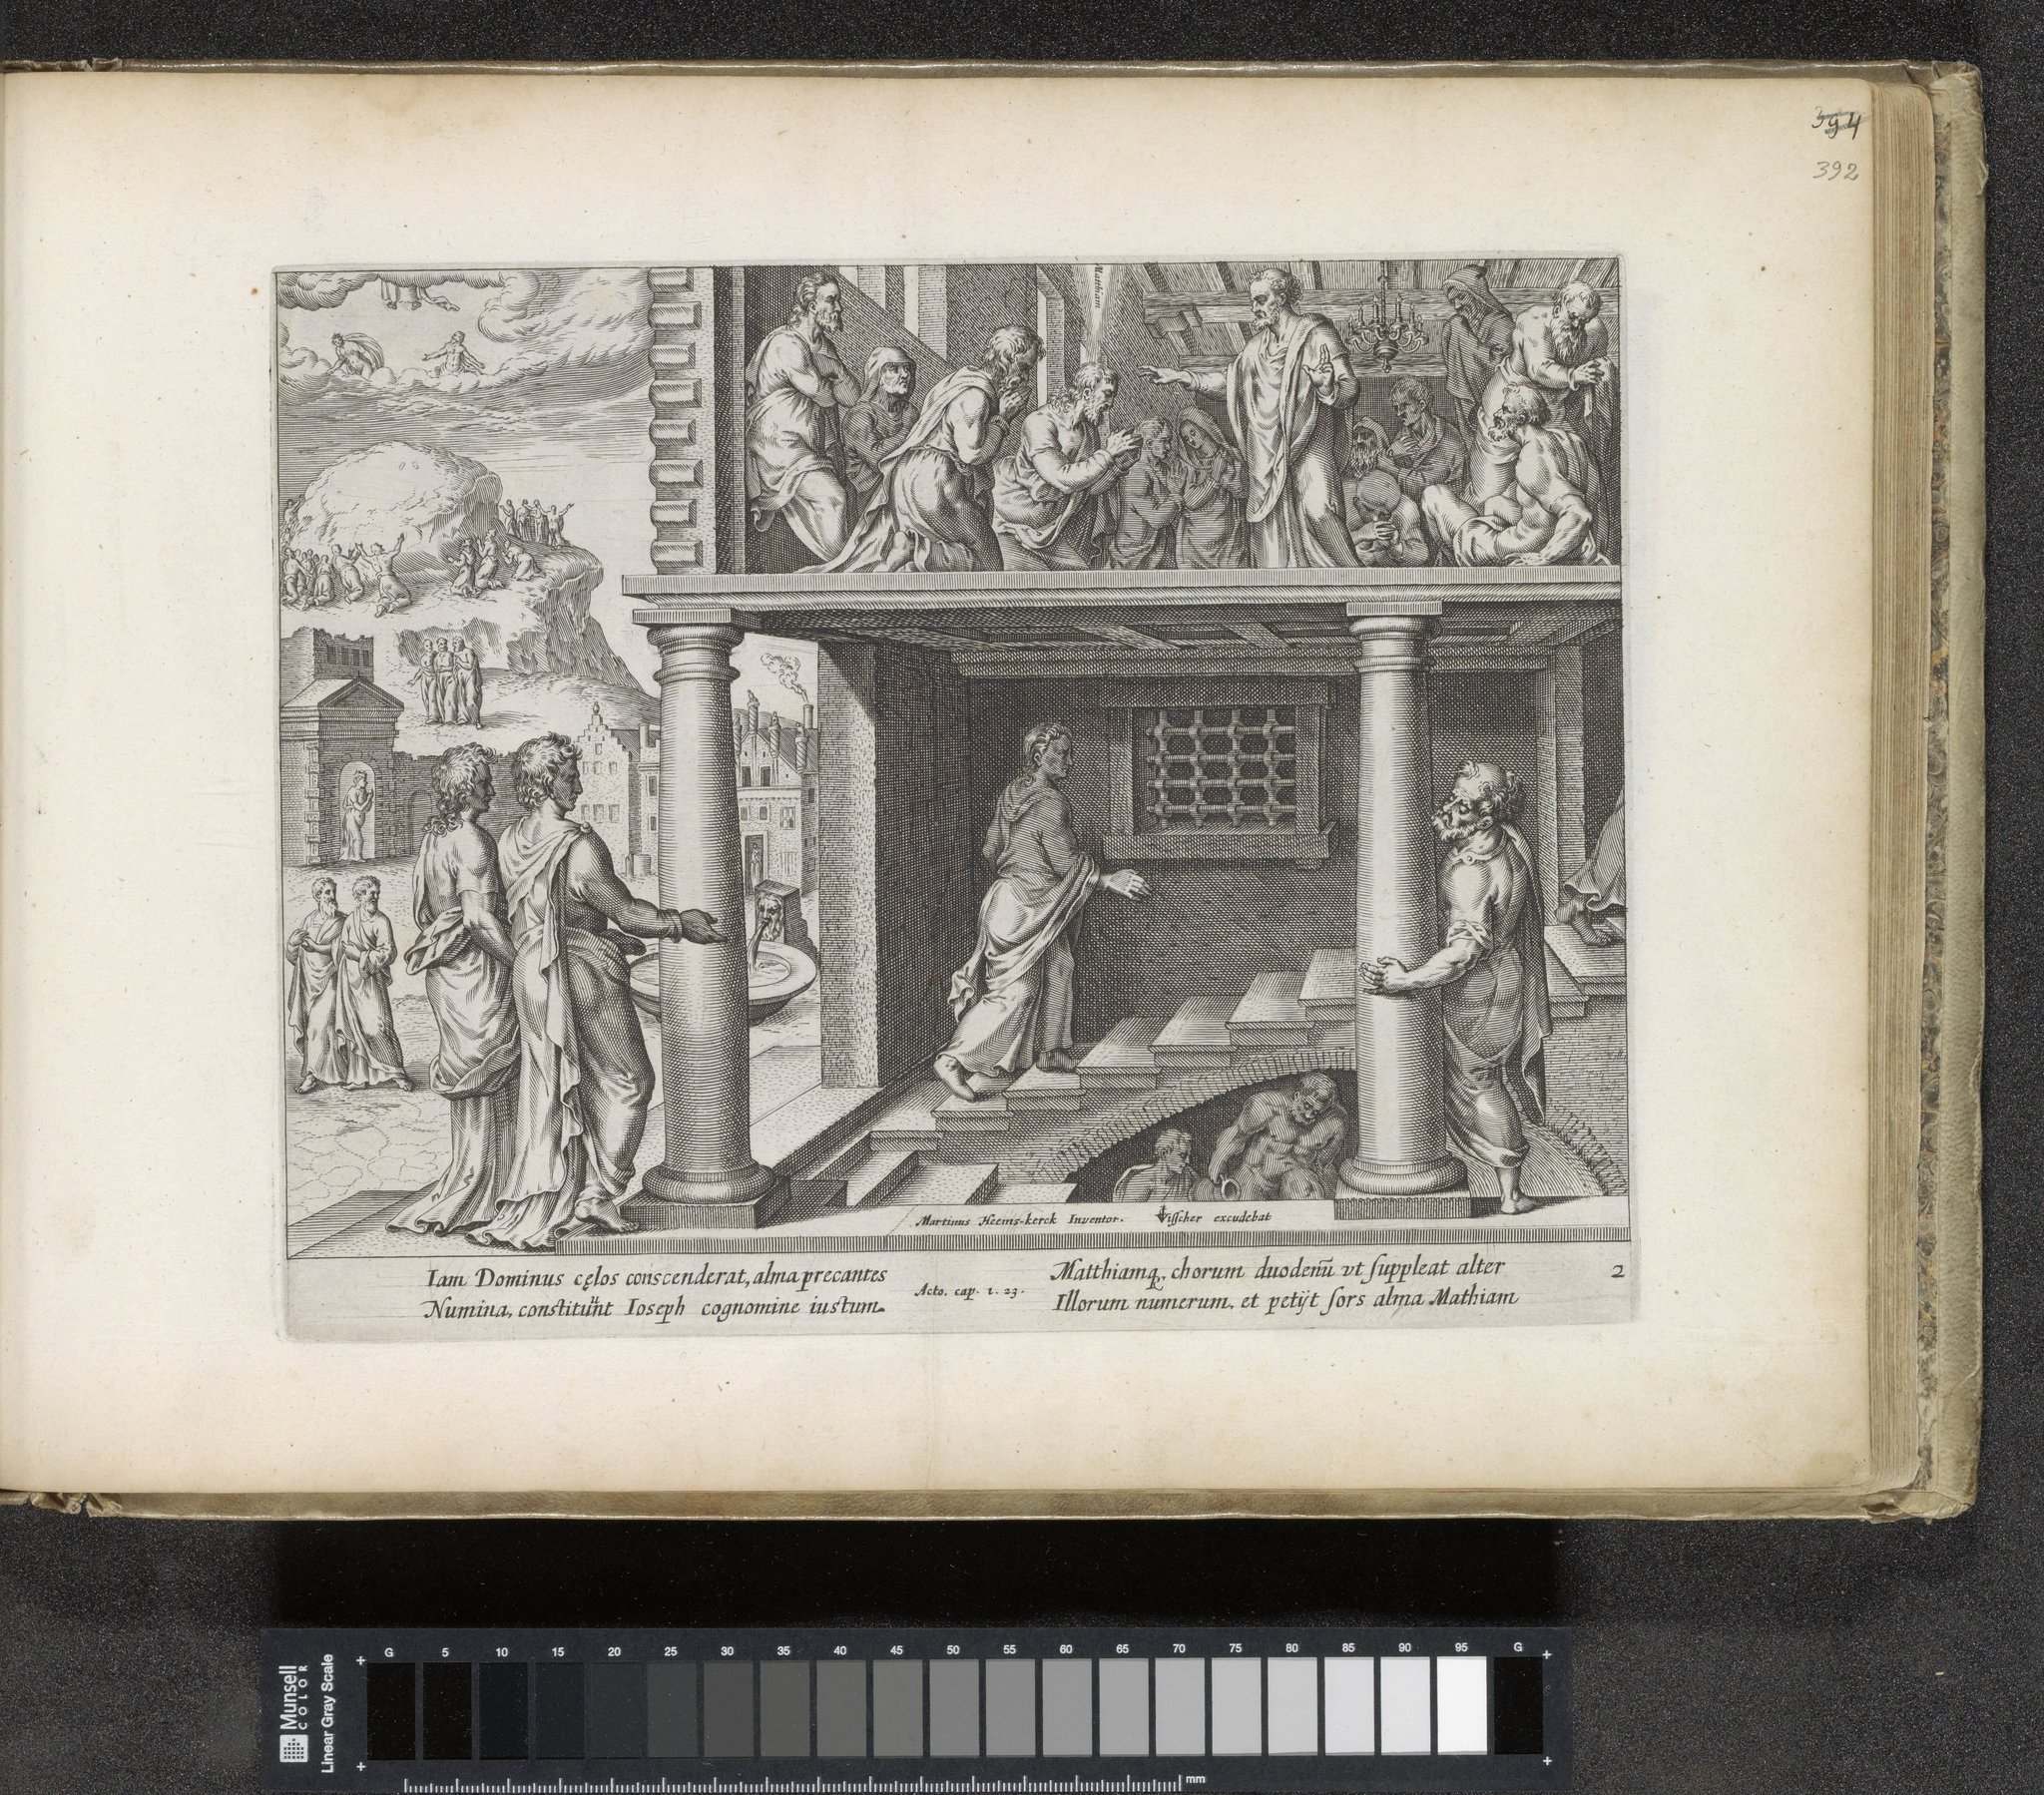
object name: album leaf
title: Hemelvaart van Christus en verkiezing van Mattias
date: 1643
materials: paper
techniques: engraving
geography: amsterdam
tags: the ascension (christ surrounded by radiant light or in a mandorla), peter, in the midst of the disciples, proposes choosing an apostle to take judas' place (acts 1:15-26)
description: Op de achtergrond de Hemelvaart van Christus op de Olijfberg. Op de voorgrond keren de apostelen terug naar Jeruzalem. Petrus wijst Mattias aan als twaalfde apostel. Onder de voorstelling een verwijzing in het Latijn naar de Bijbeltekst in Hand. 1:23. Deze prent maakt deel uit van een album.